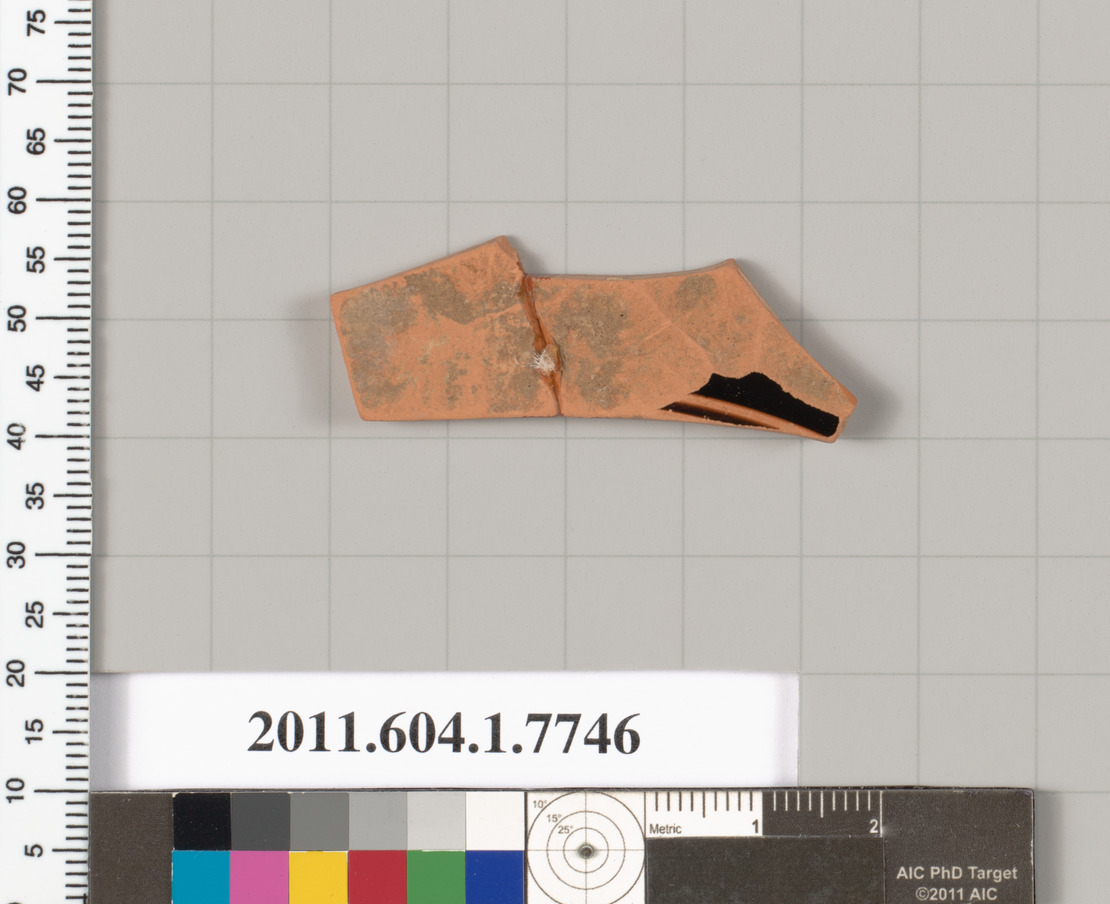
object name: kylix fragment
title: Terracotta fragment of a kylix (drinking cup)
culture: greek, attic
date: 460-450 BCE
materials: terracotta